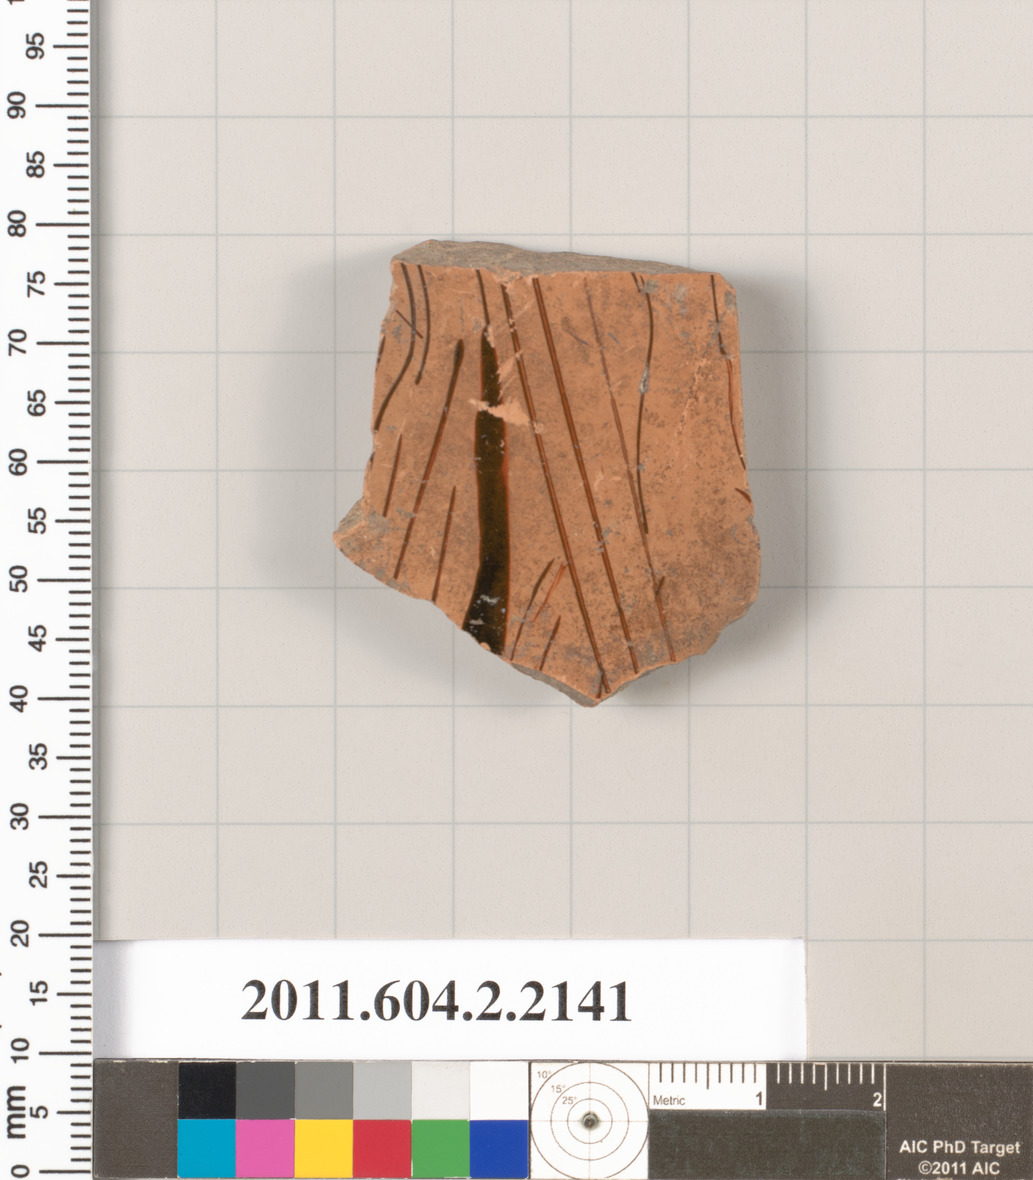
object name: pot fragment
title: Terracotta fragment of a pot; glazed on the inside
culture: greek, attic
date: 450-426 BCE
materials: terracotta